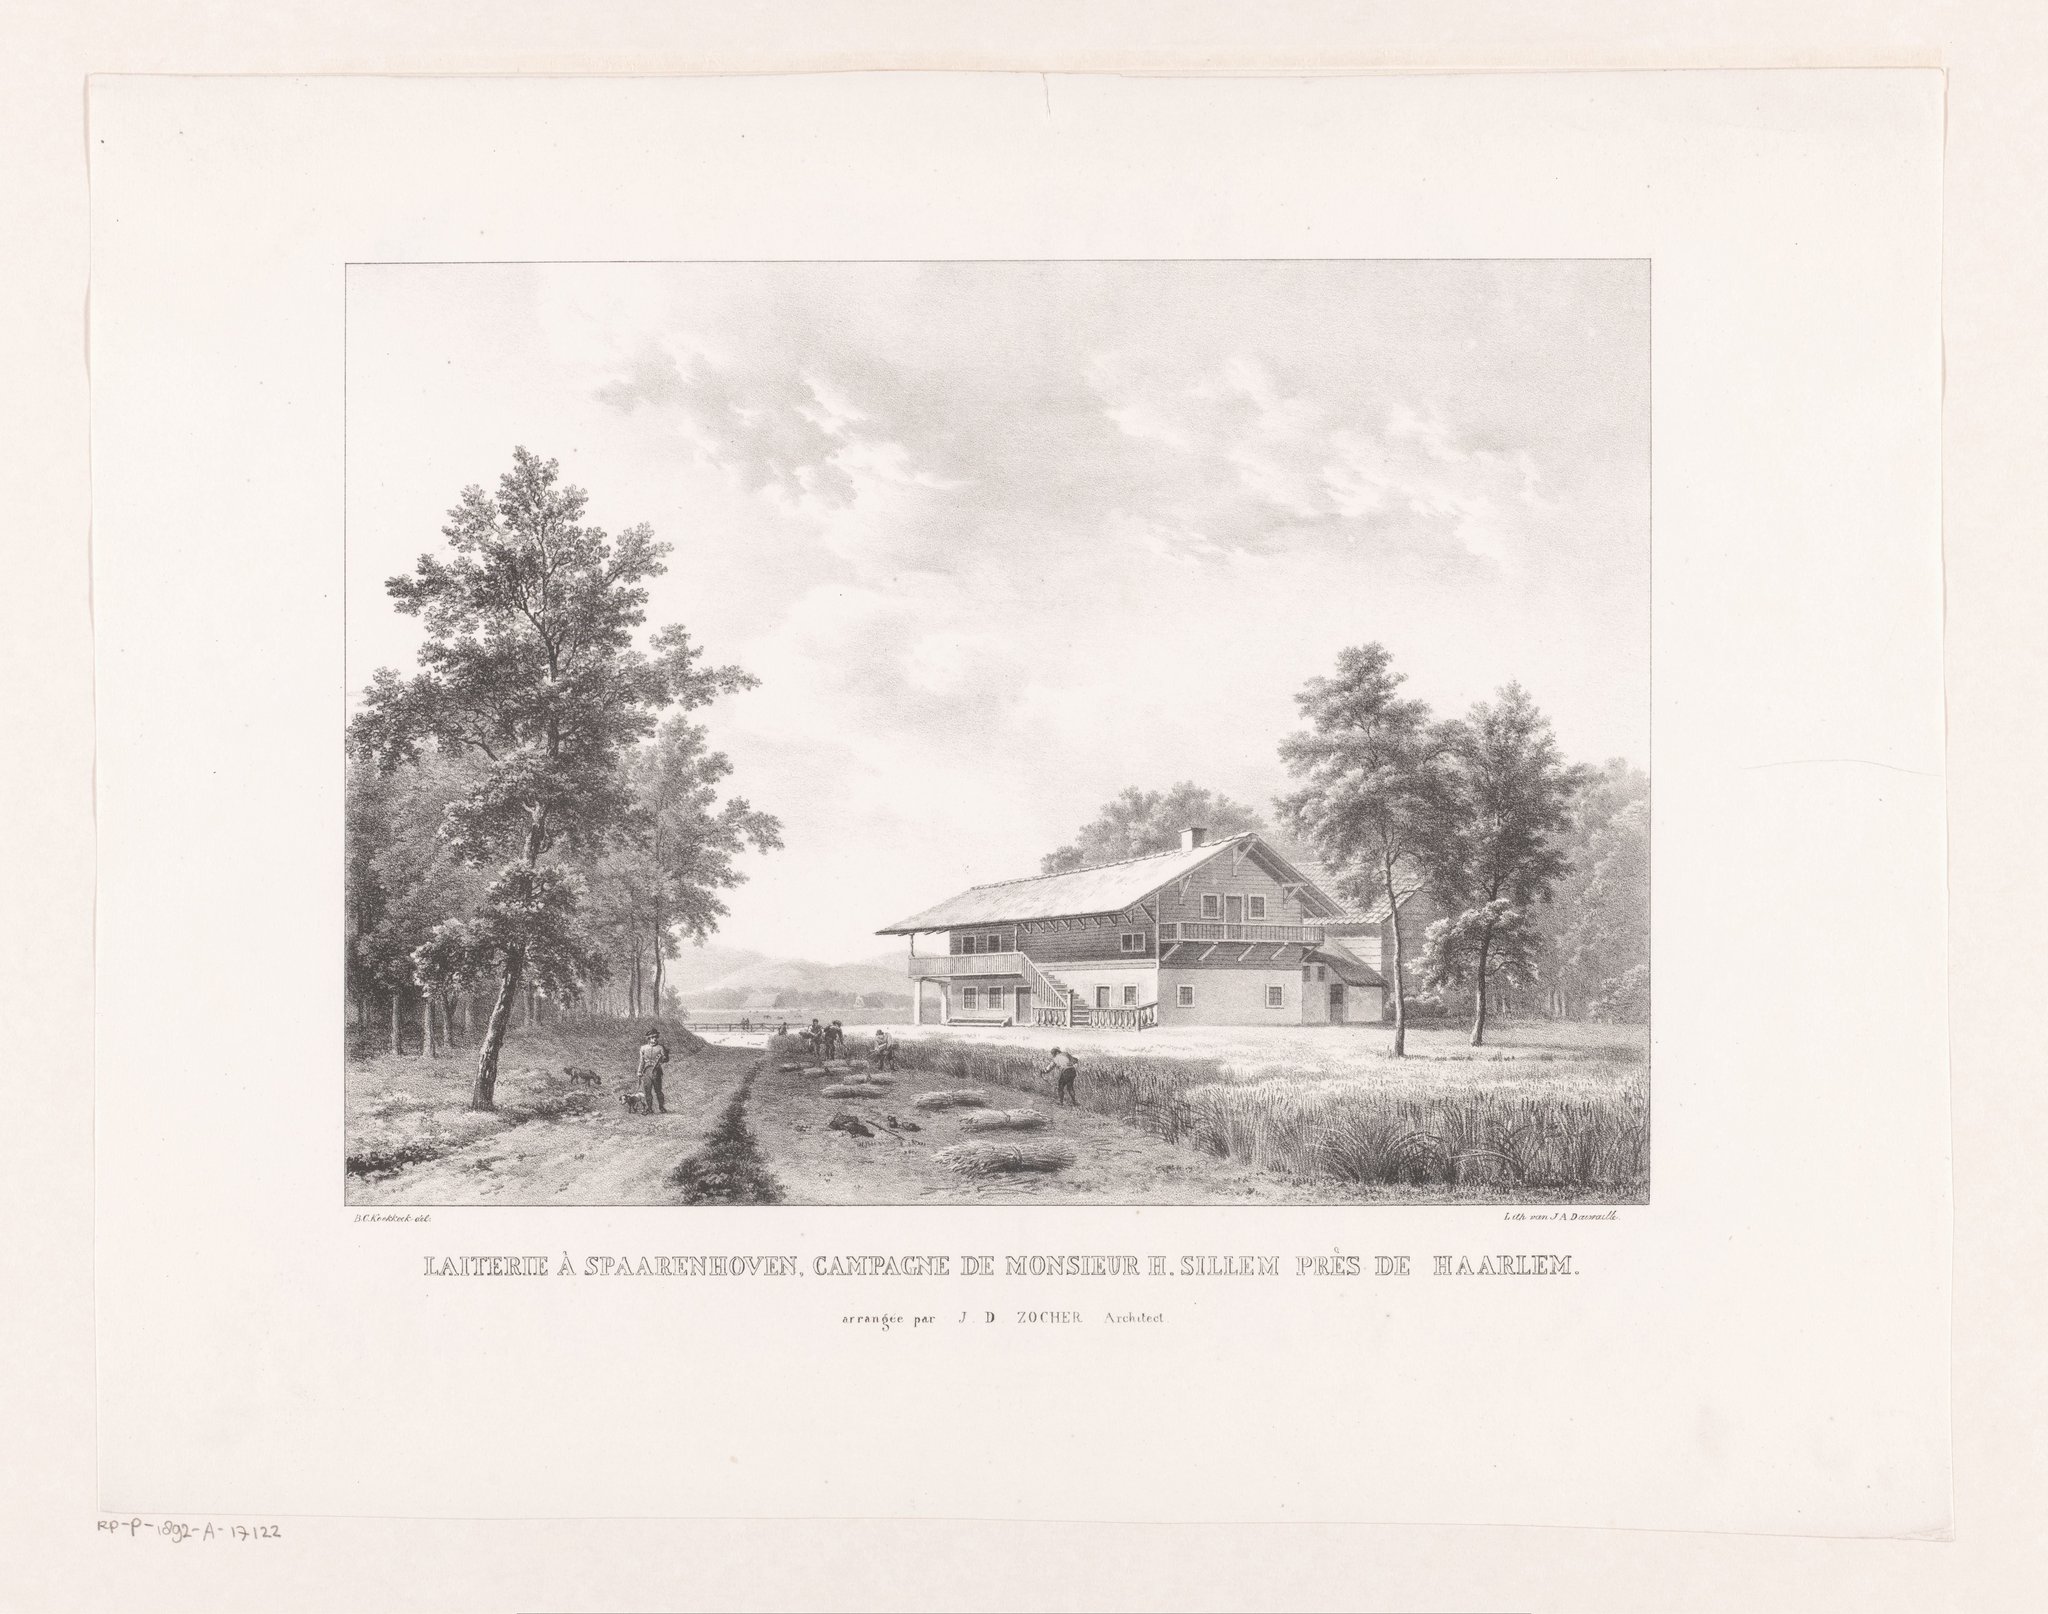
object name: print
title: Melkerij op landgoed Spaarnhove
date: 1828-1833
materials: paper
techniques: lithograph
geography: amsterdam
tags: haarlem, designer, johan david zocher, sheaf, reaping, picking, mowing ~ harvest, farm (building)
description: Jérome (Hieronymus) Sillem (1768-1833) had de hofstede in 1812 gekocht en liet deze in 1823 herinrichten door Jan David Zocher jr. (1791-1870). Volgens Nollert werden deze litho's gemaakt in opdracht in Zocher, nog voor de uitvoering van diens ontwerpen. Zie Nollert, 1997.